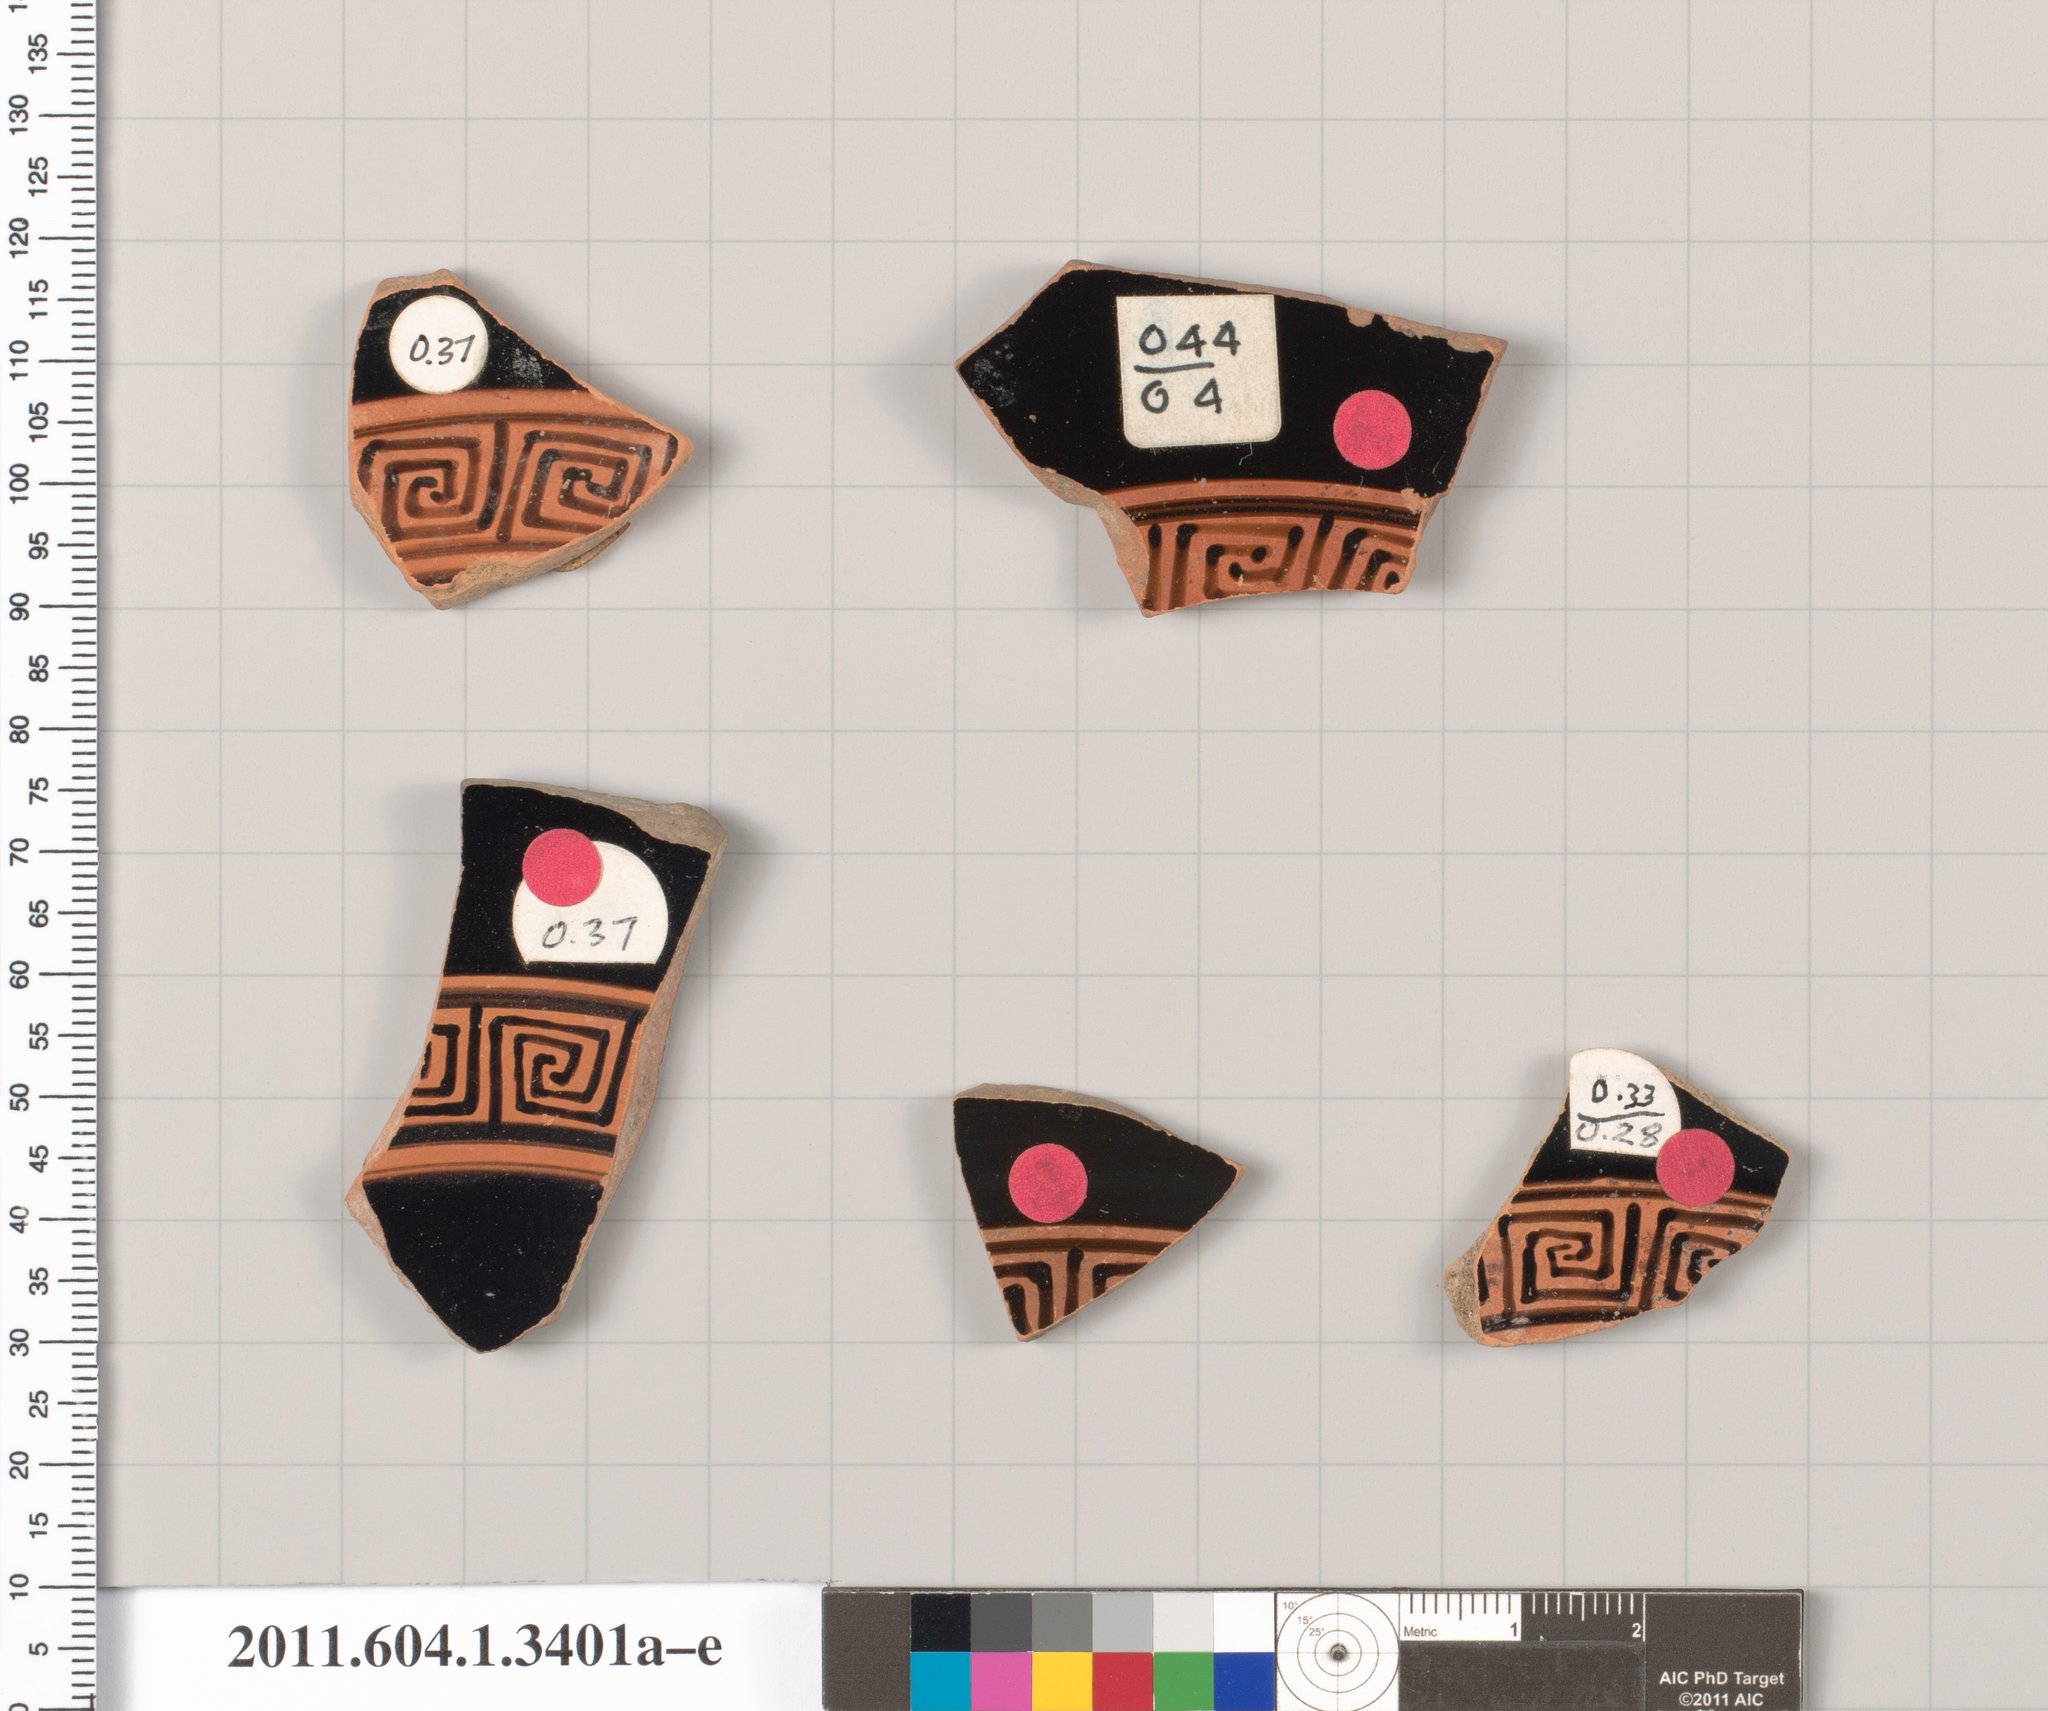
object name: kylix fragment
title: Terracotta fragments of kylikes (drinking cups)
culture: greek, attic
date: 510-470 BCE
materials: terracotta